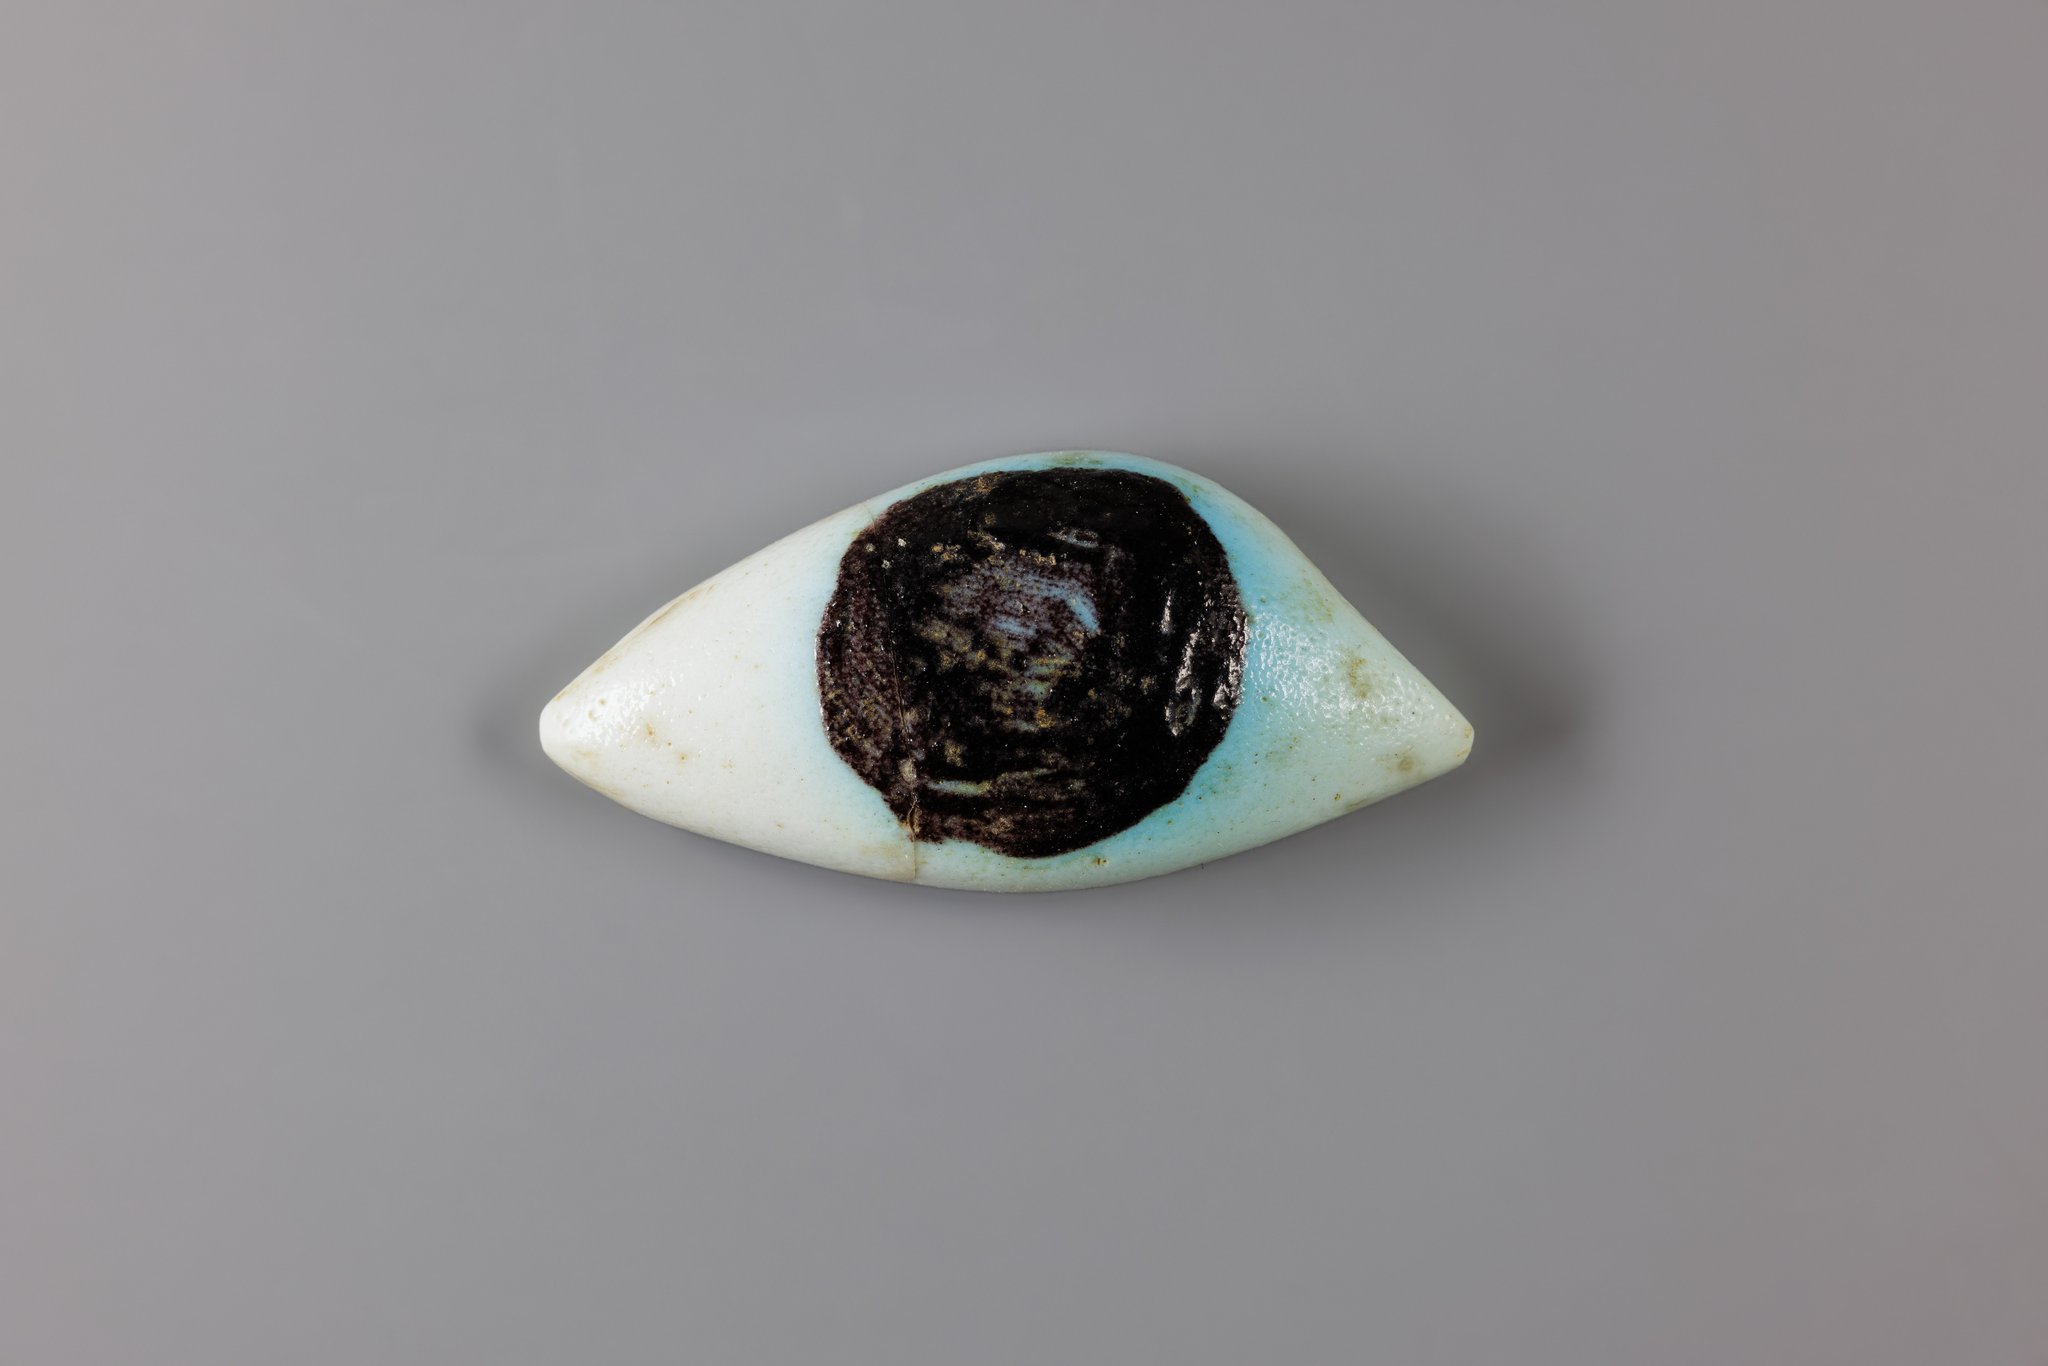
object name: inlay, eye, k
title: Eye inlay from coffin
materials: faience, glaze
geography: egypt